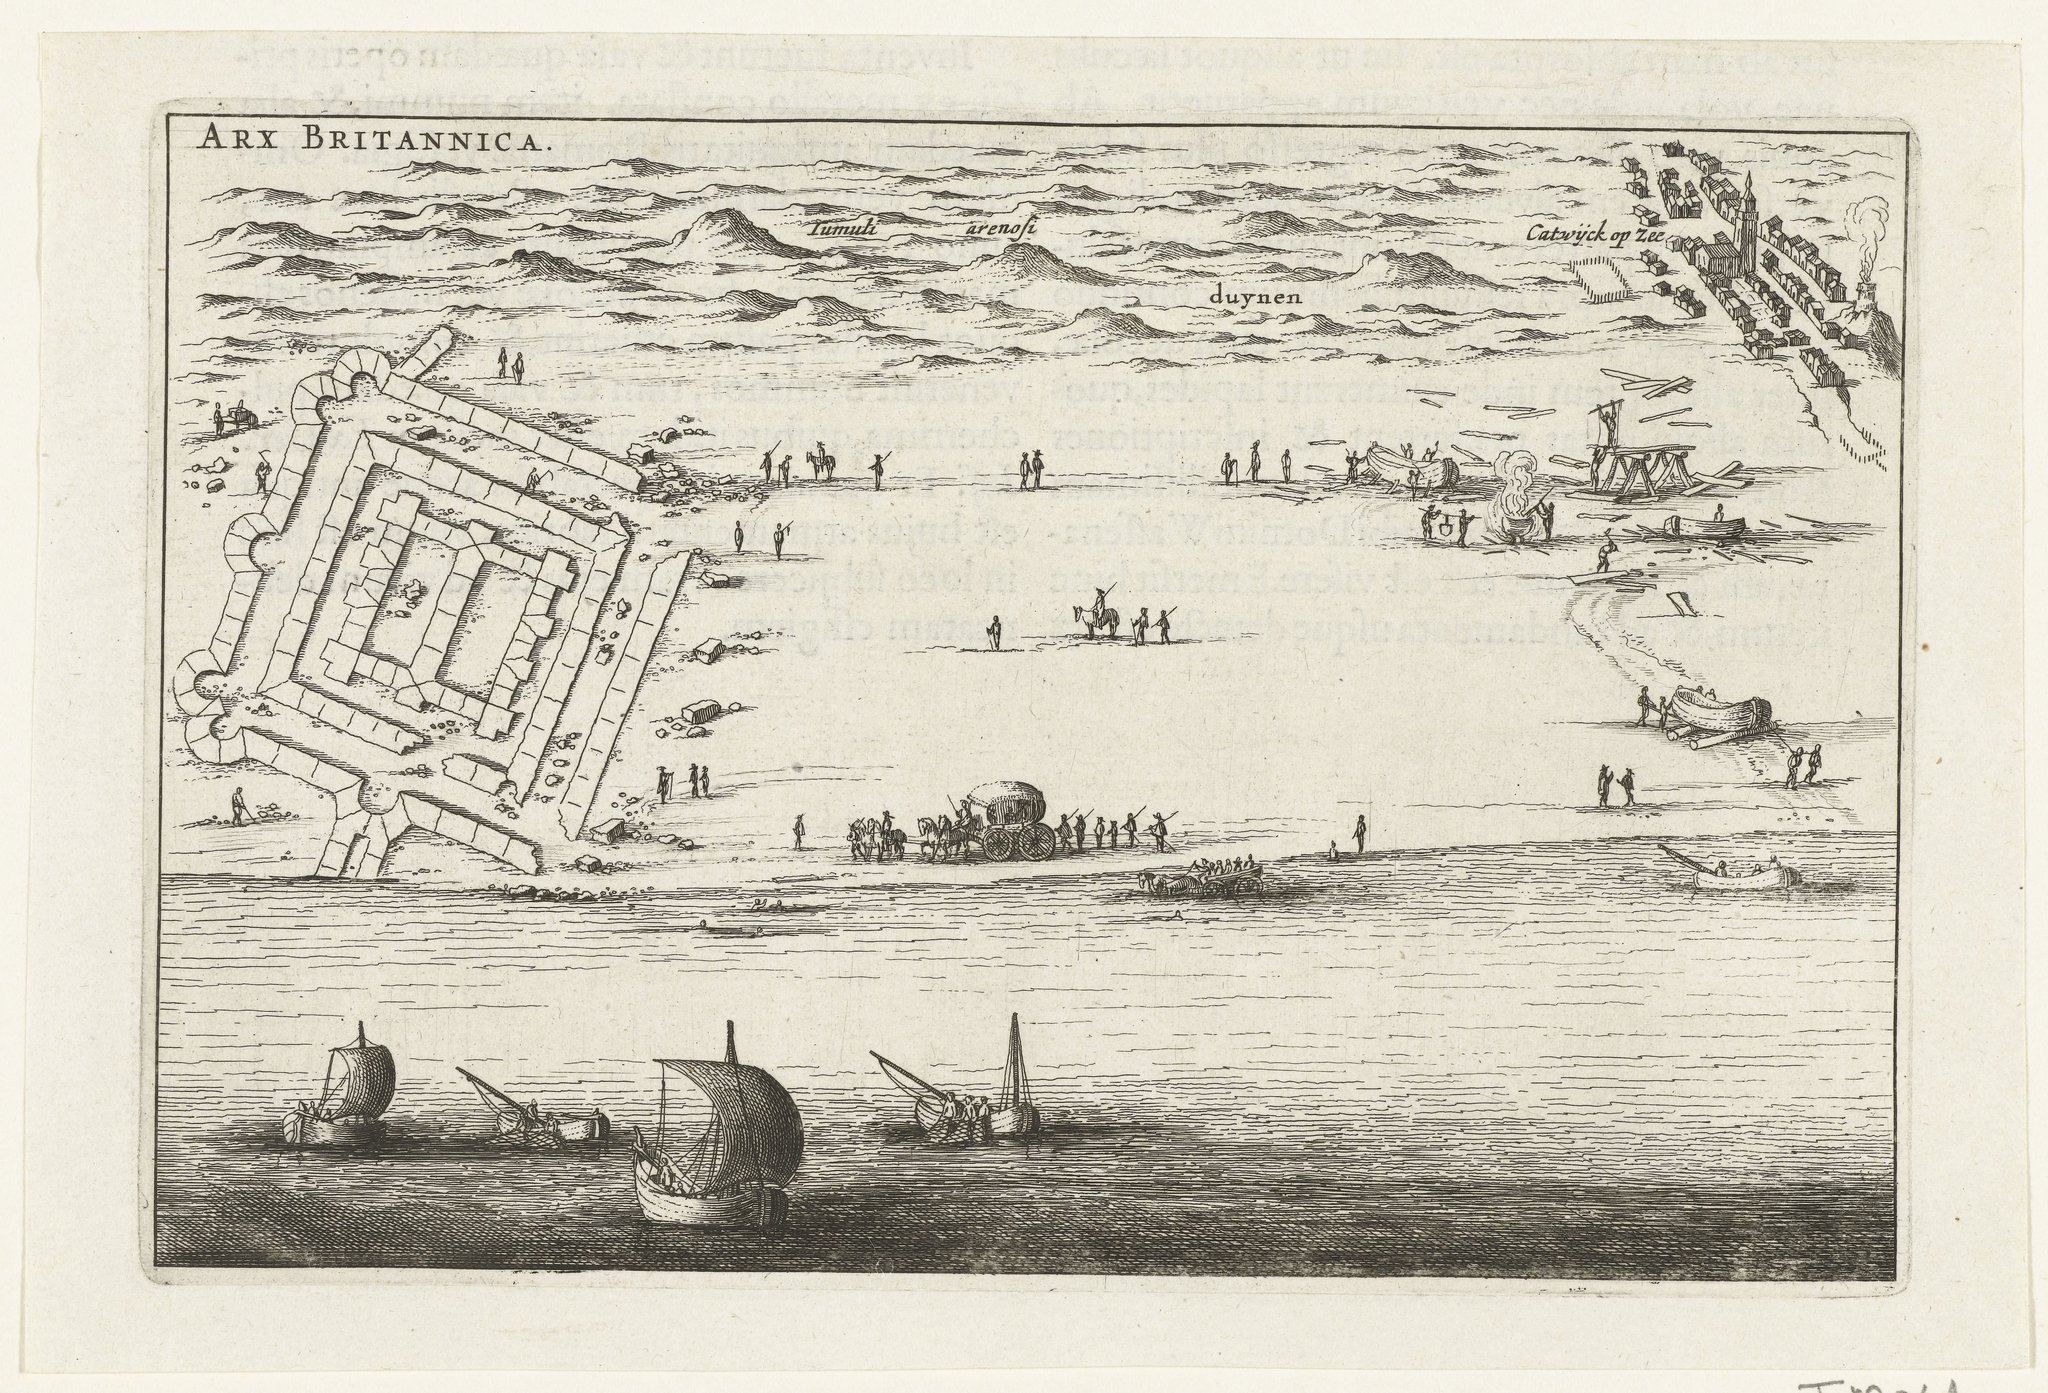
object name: print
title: De Brittenburg bij Katwijk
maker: Anonymous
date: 1658-1660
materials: paper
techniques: etching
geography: northern netherlands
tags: landscape with ruins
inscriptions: collector's mark: Lugt 2228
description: Kustlandschap in vogelvlucht met een plattegrond van de fundamenten van het Huis te Britten, op de voorgrond boten op zee.